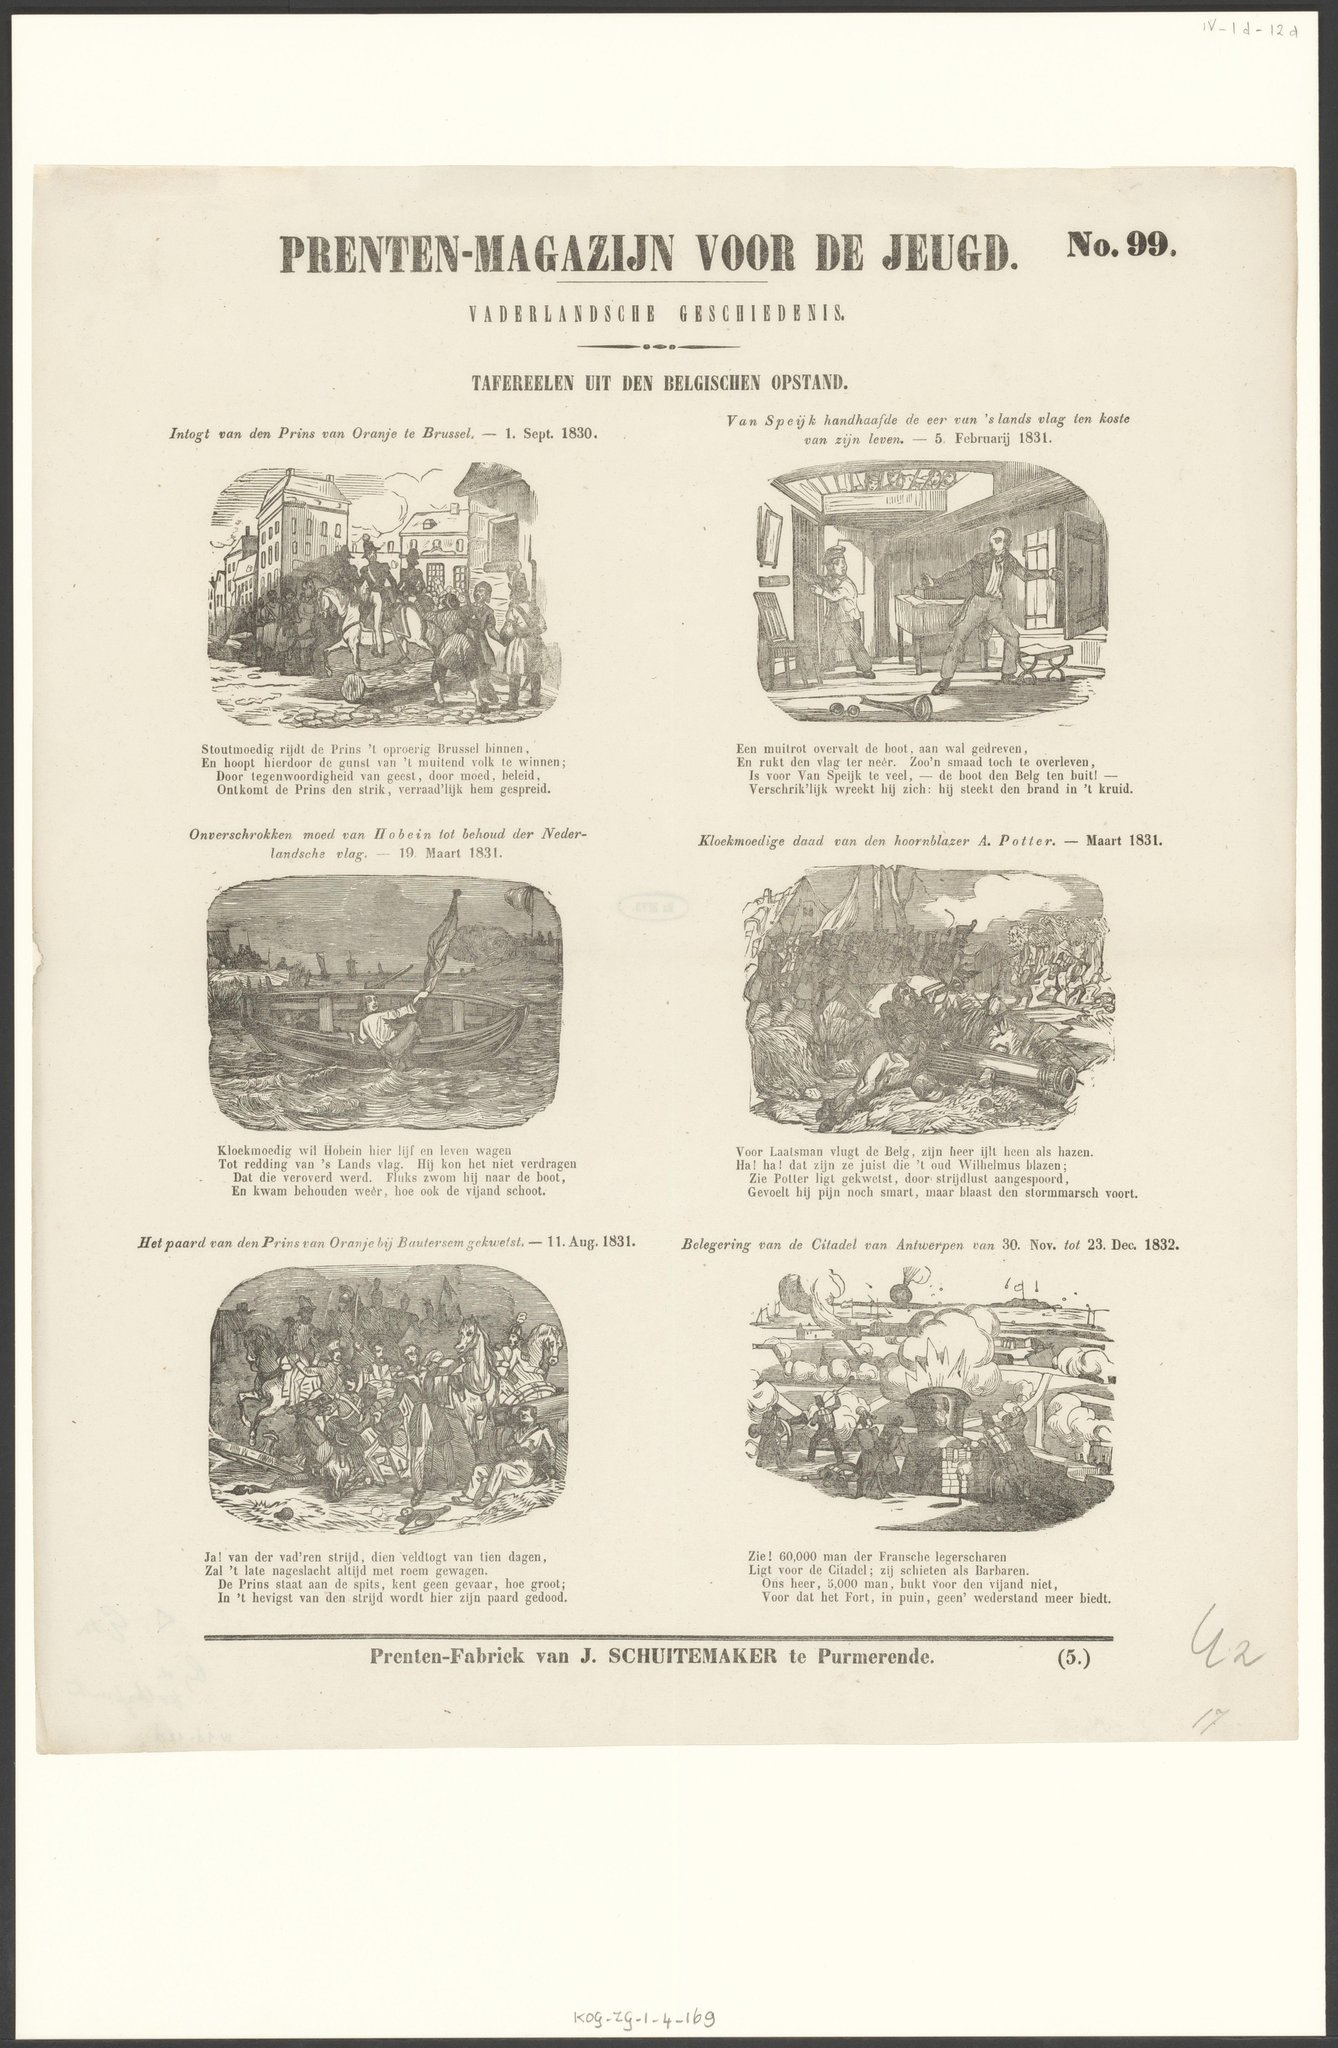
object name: popular print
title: Vaderlandsche geschiedenis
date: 1842-1869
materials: paper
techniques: letterpress printing, engraving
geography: purmerend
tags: amsterdam, antwerp, jan van speyk, the hague, william ii of the netherlands, battle, brussels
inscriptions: collector's mark: Lugt 2228